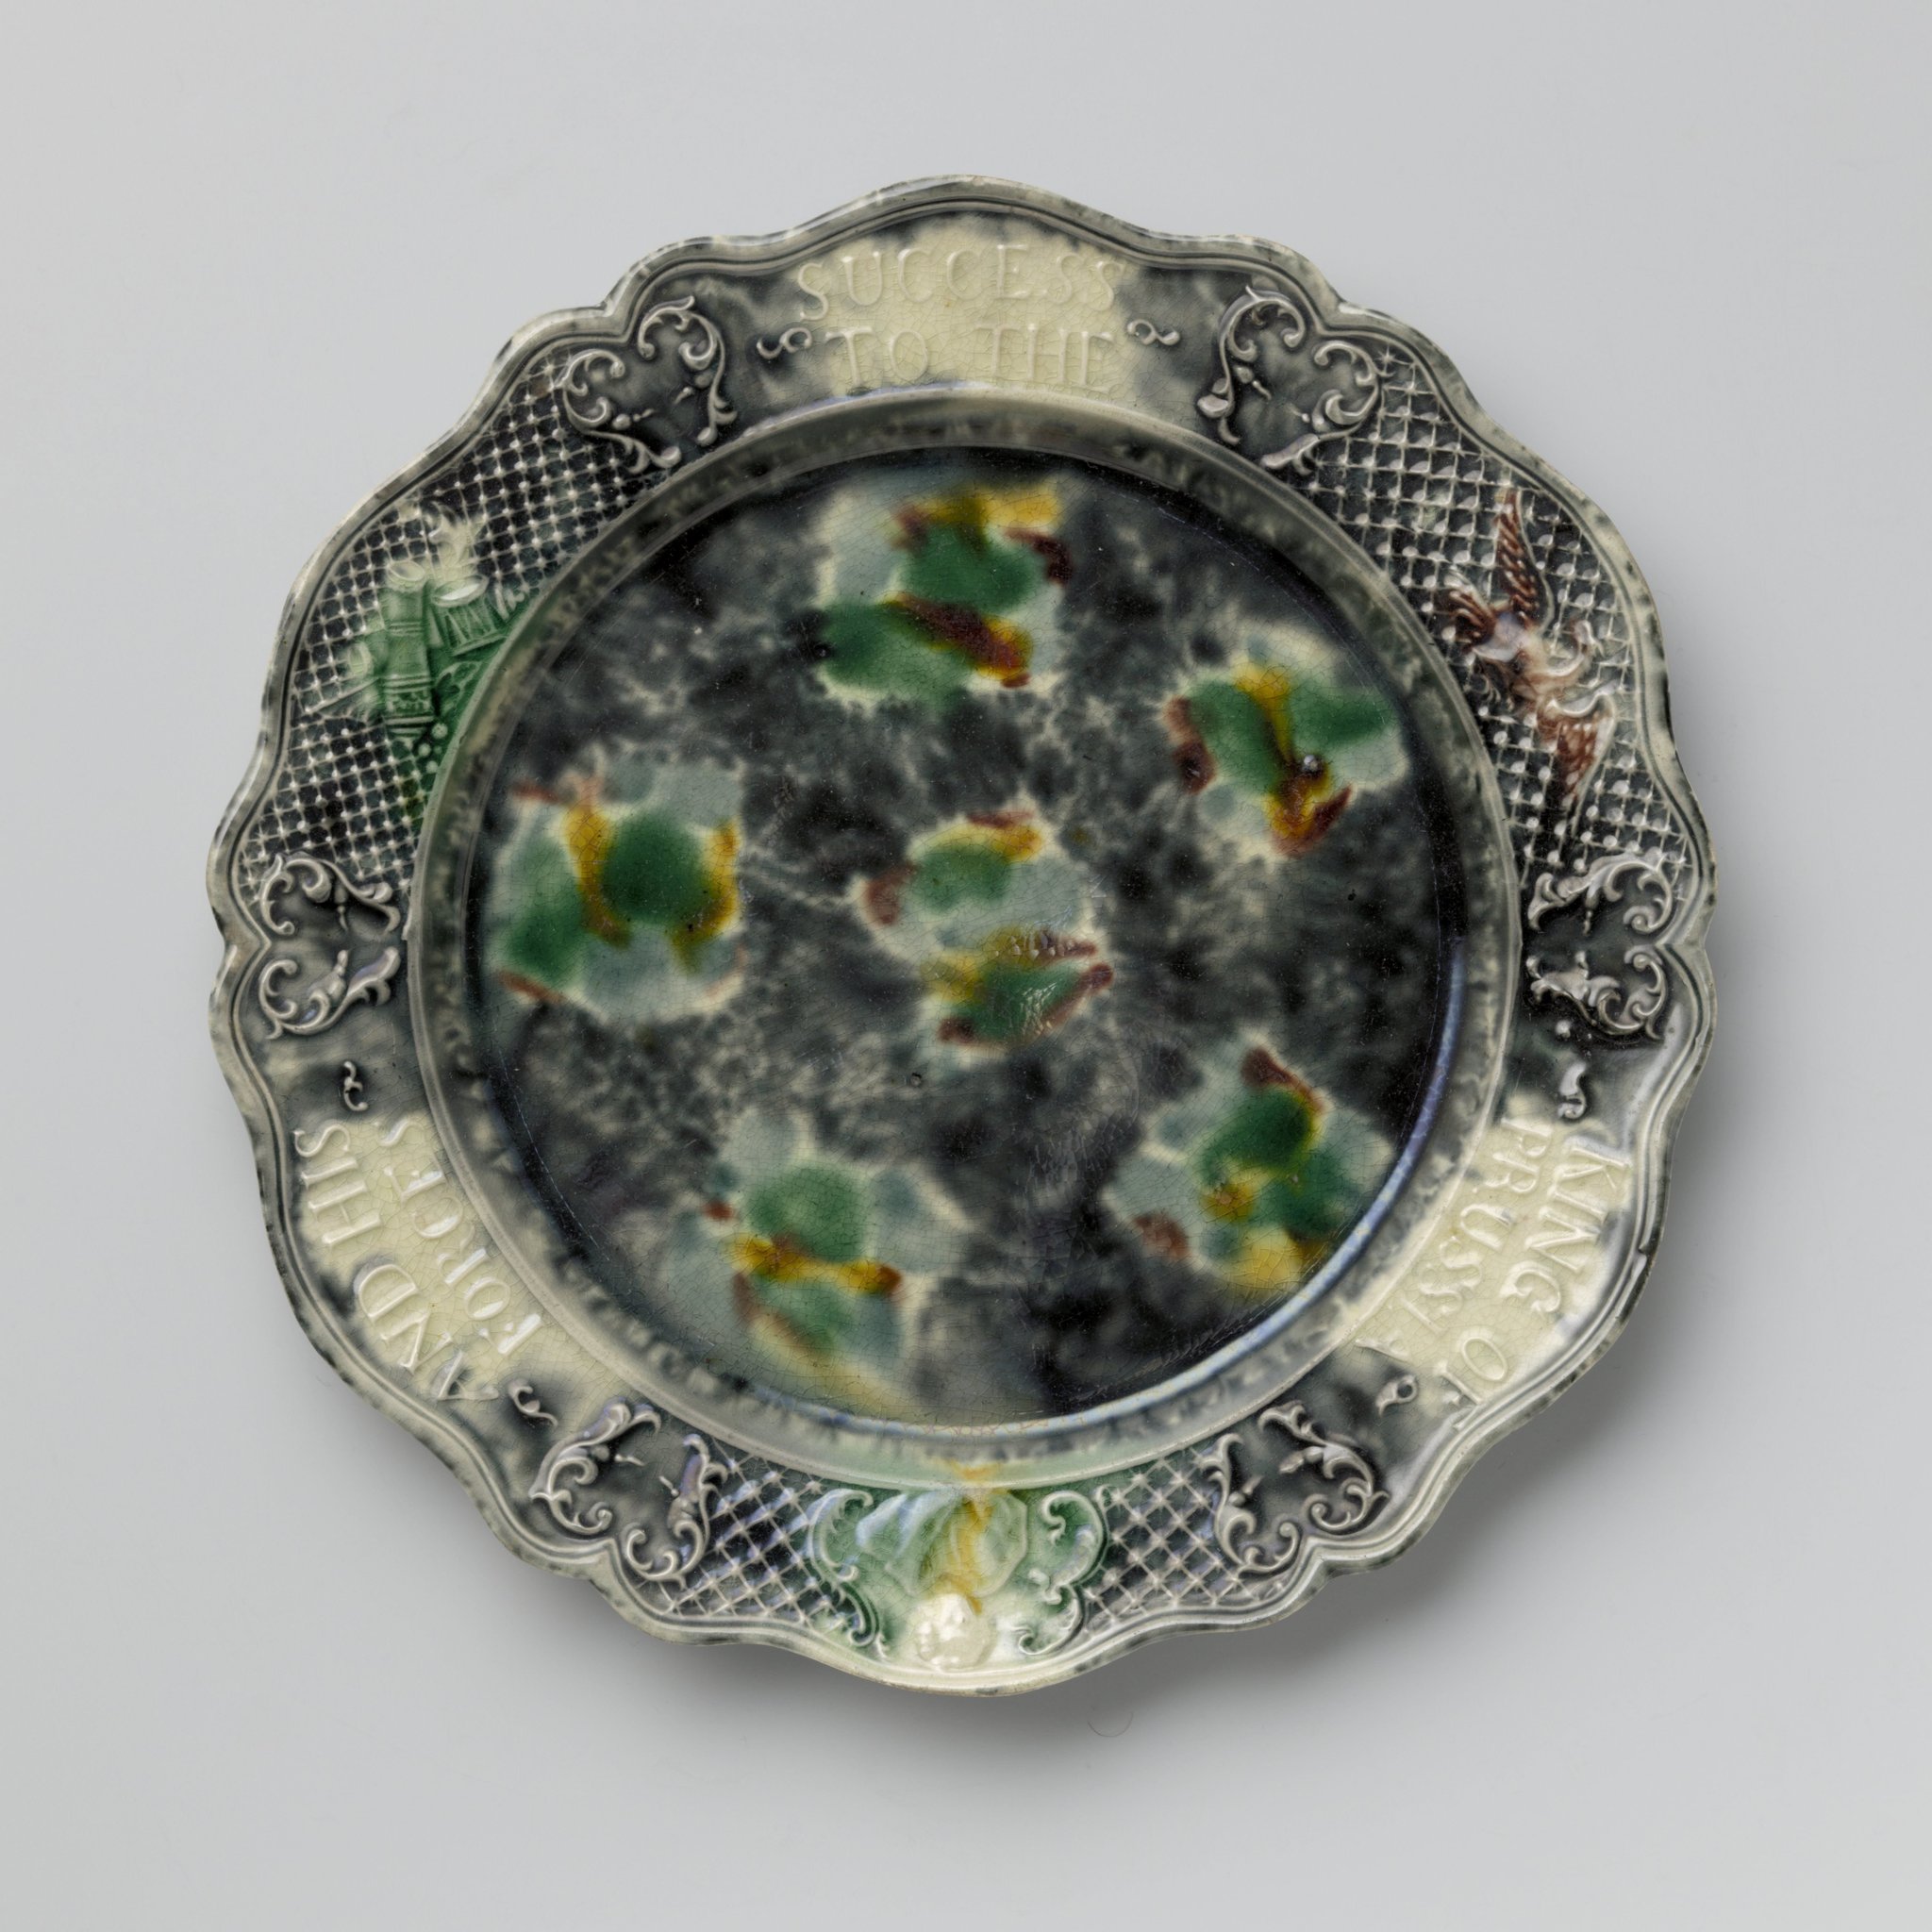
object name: plate dish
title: Rond bord van hardgebakken aardewerk; Staffordshire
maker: Anonymous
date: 1756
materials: earthenware, glaze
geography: england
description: Plate with portrait of Frederick the Great of Prussia. Creamware. Made after the outbreak of the Seven Years War (1756 - 1763). England, Staffordshire, c. 1756. Mrs A. van der Feen bequest, 1986.